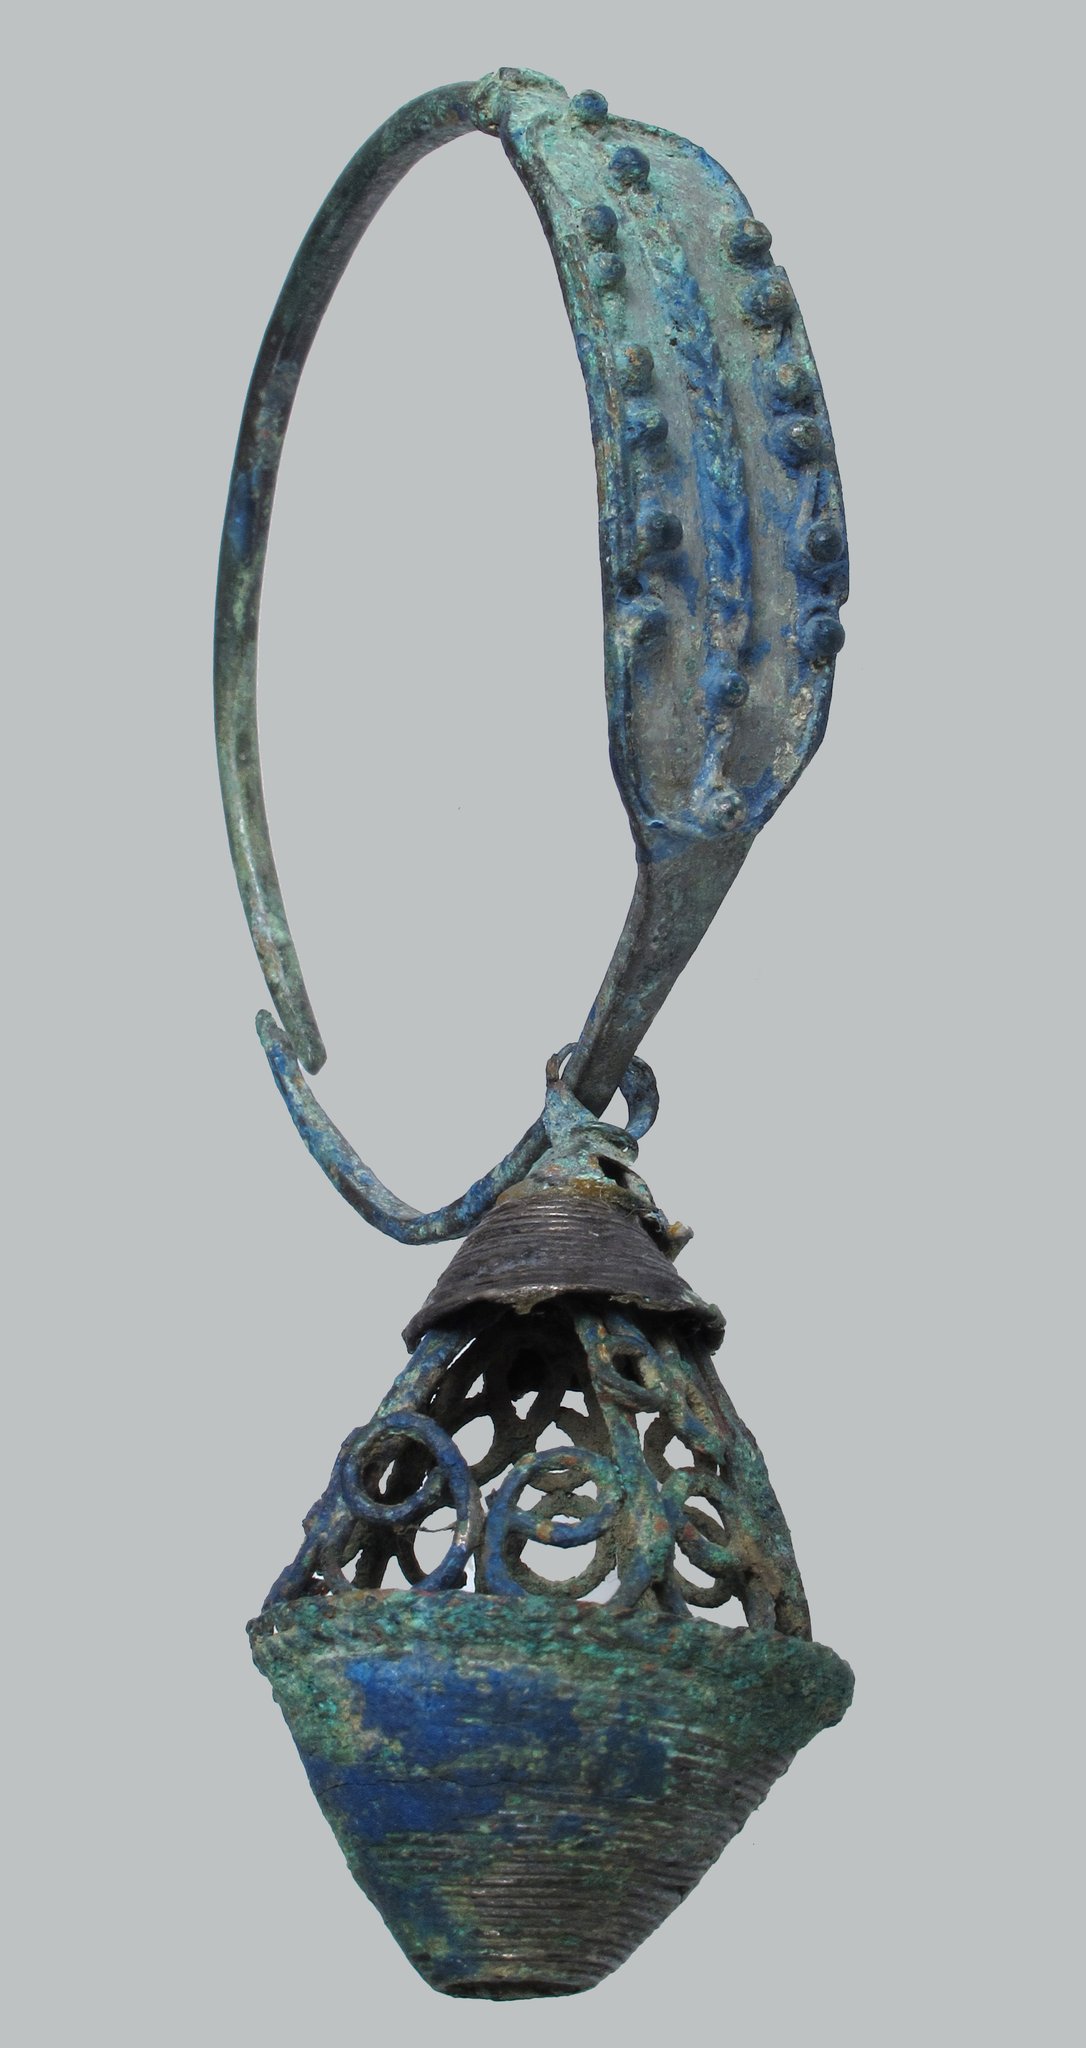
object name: earring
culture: avar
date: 701-900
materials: copper alloy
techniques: filigree